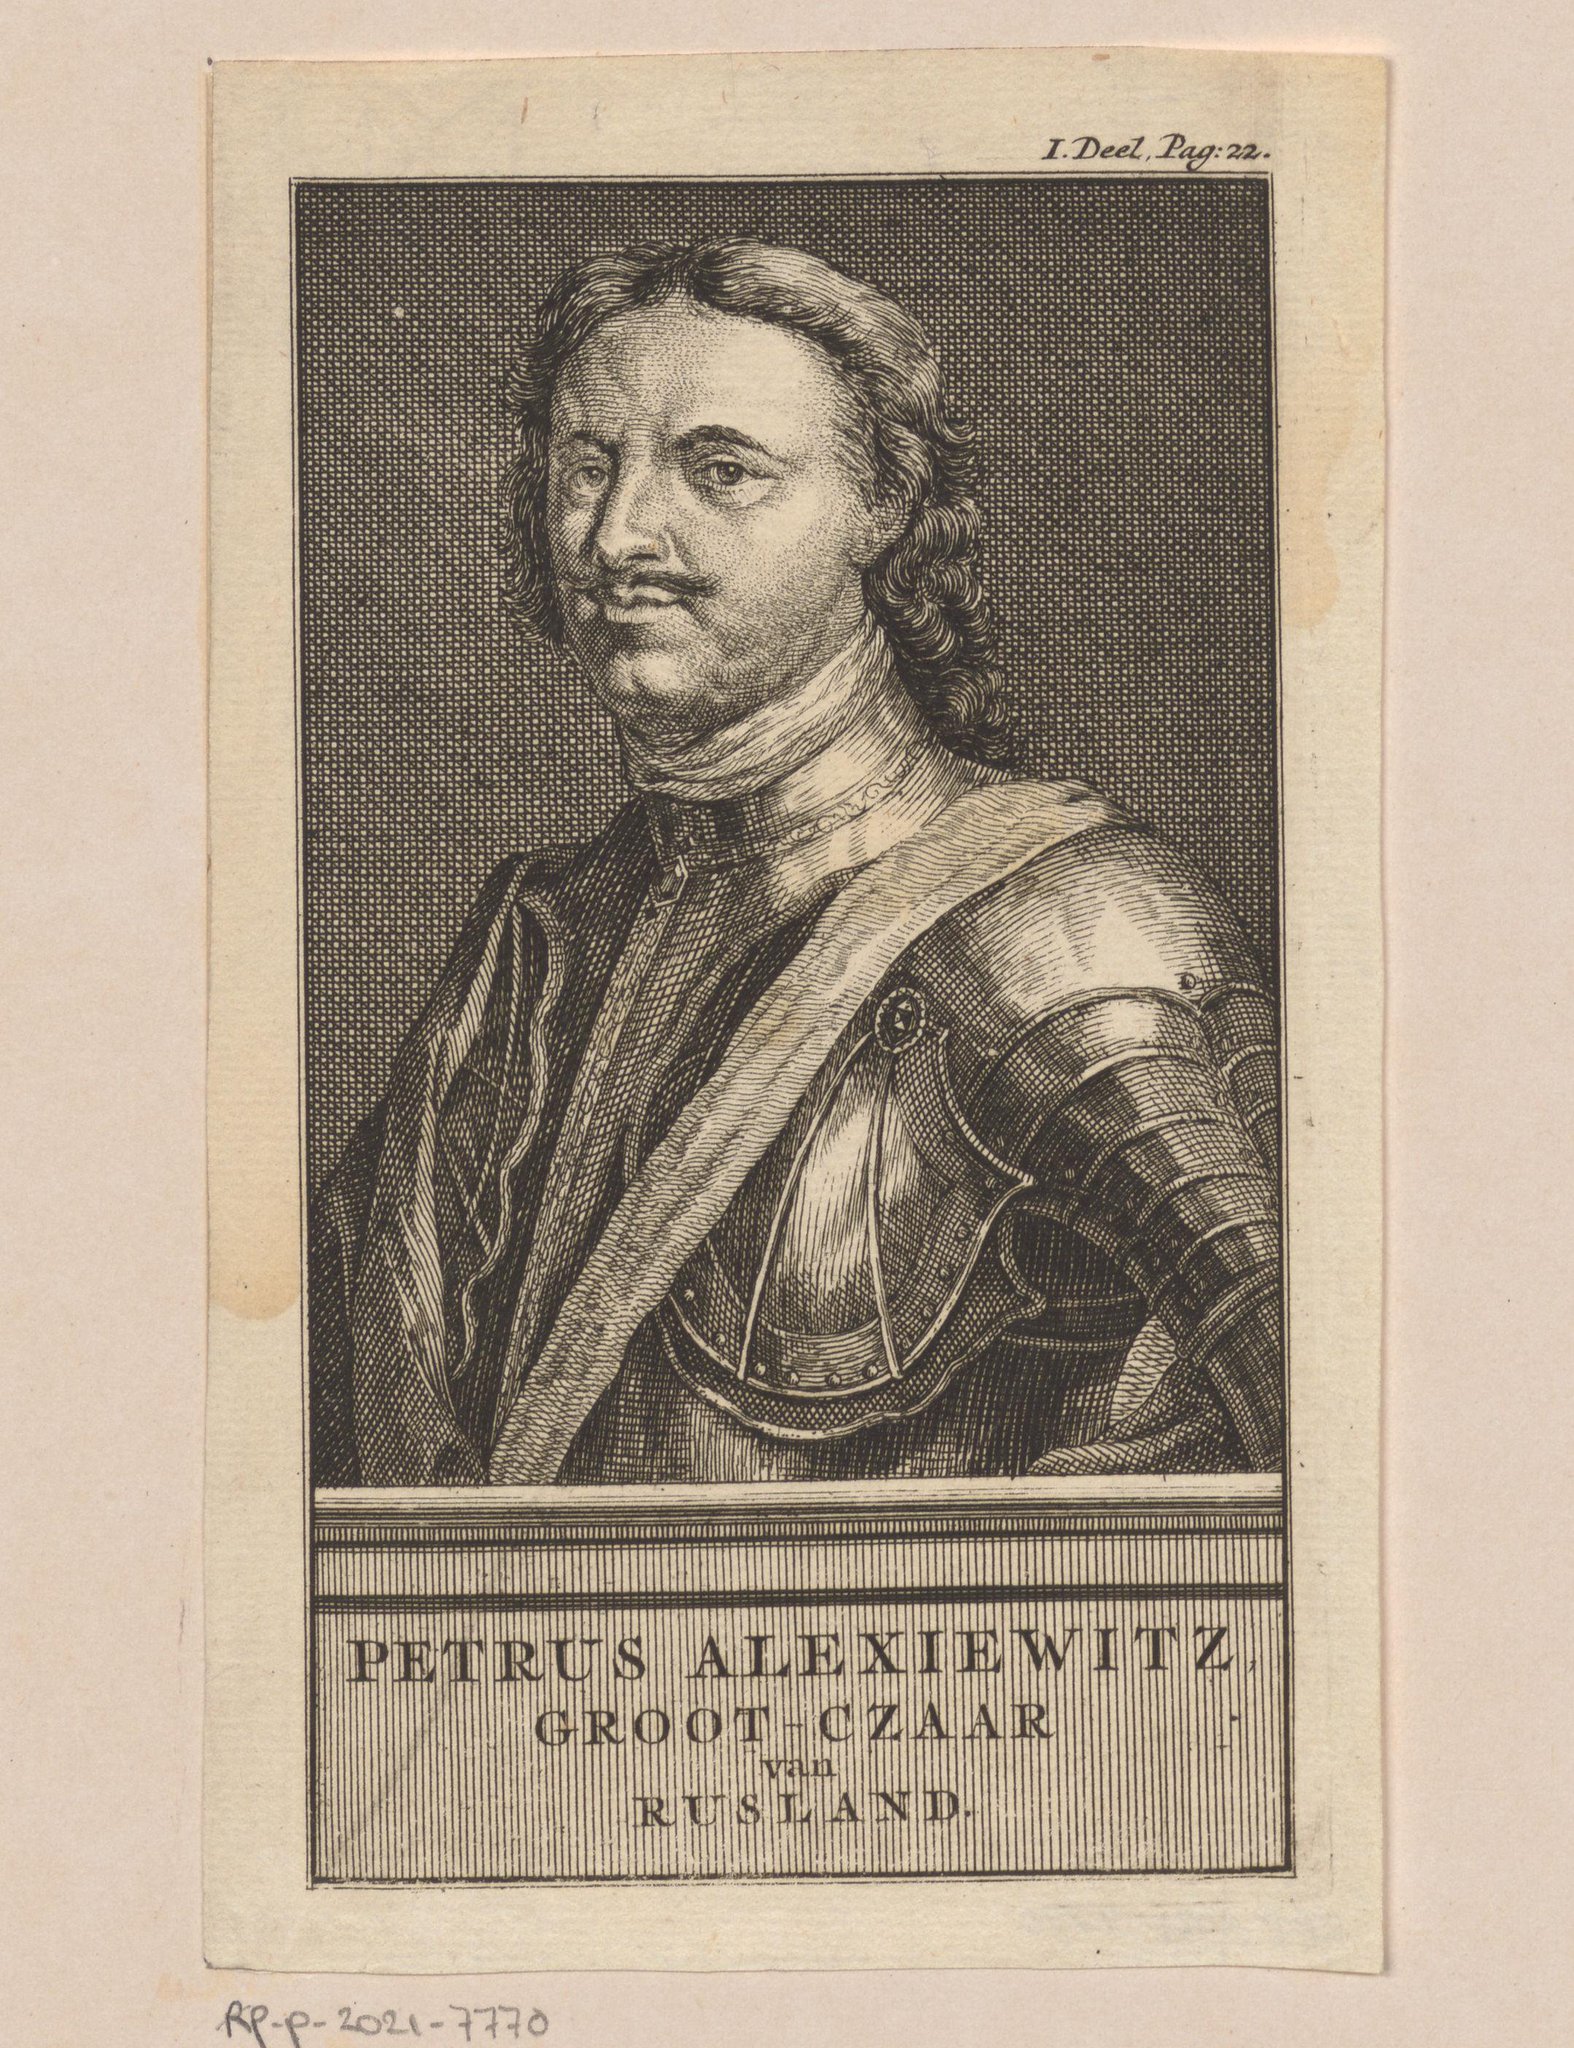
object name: book illustration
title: Portret van Peter I de Grote, tsaar van Rusland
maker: Anonymous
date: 1700-1799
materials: paper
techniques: engraving, etching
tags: peter i de grote (tsaar van rusland), armour, adult man, historical persons